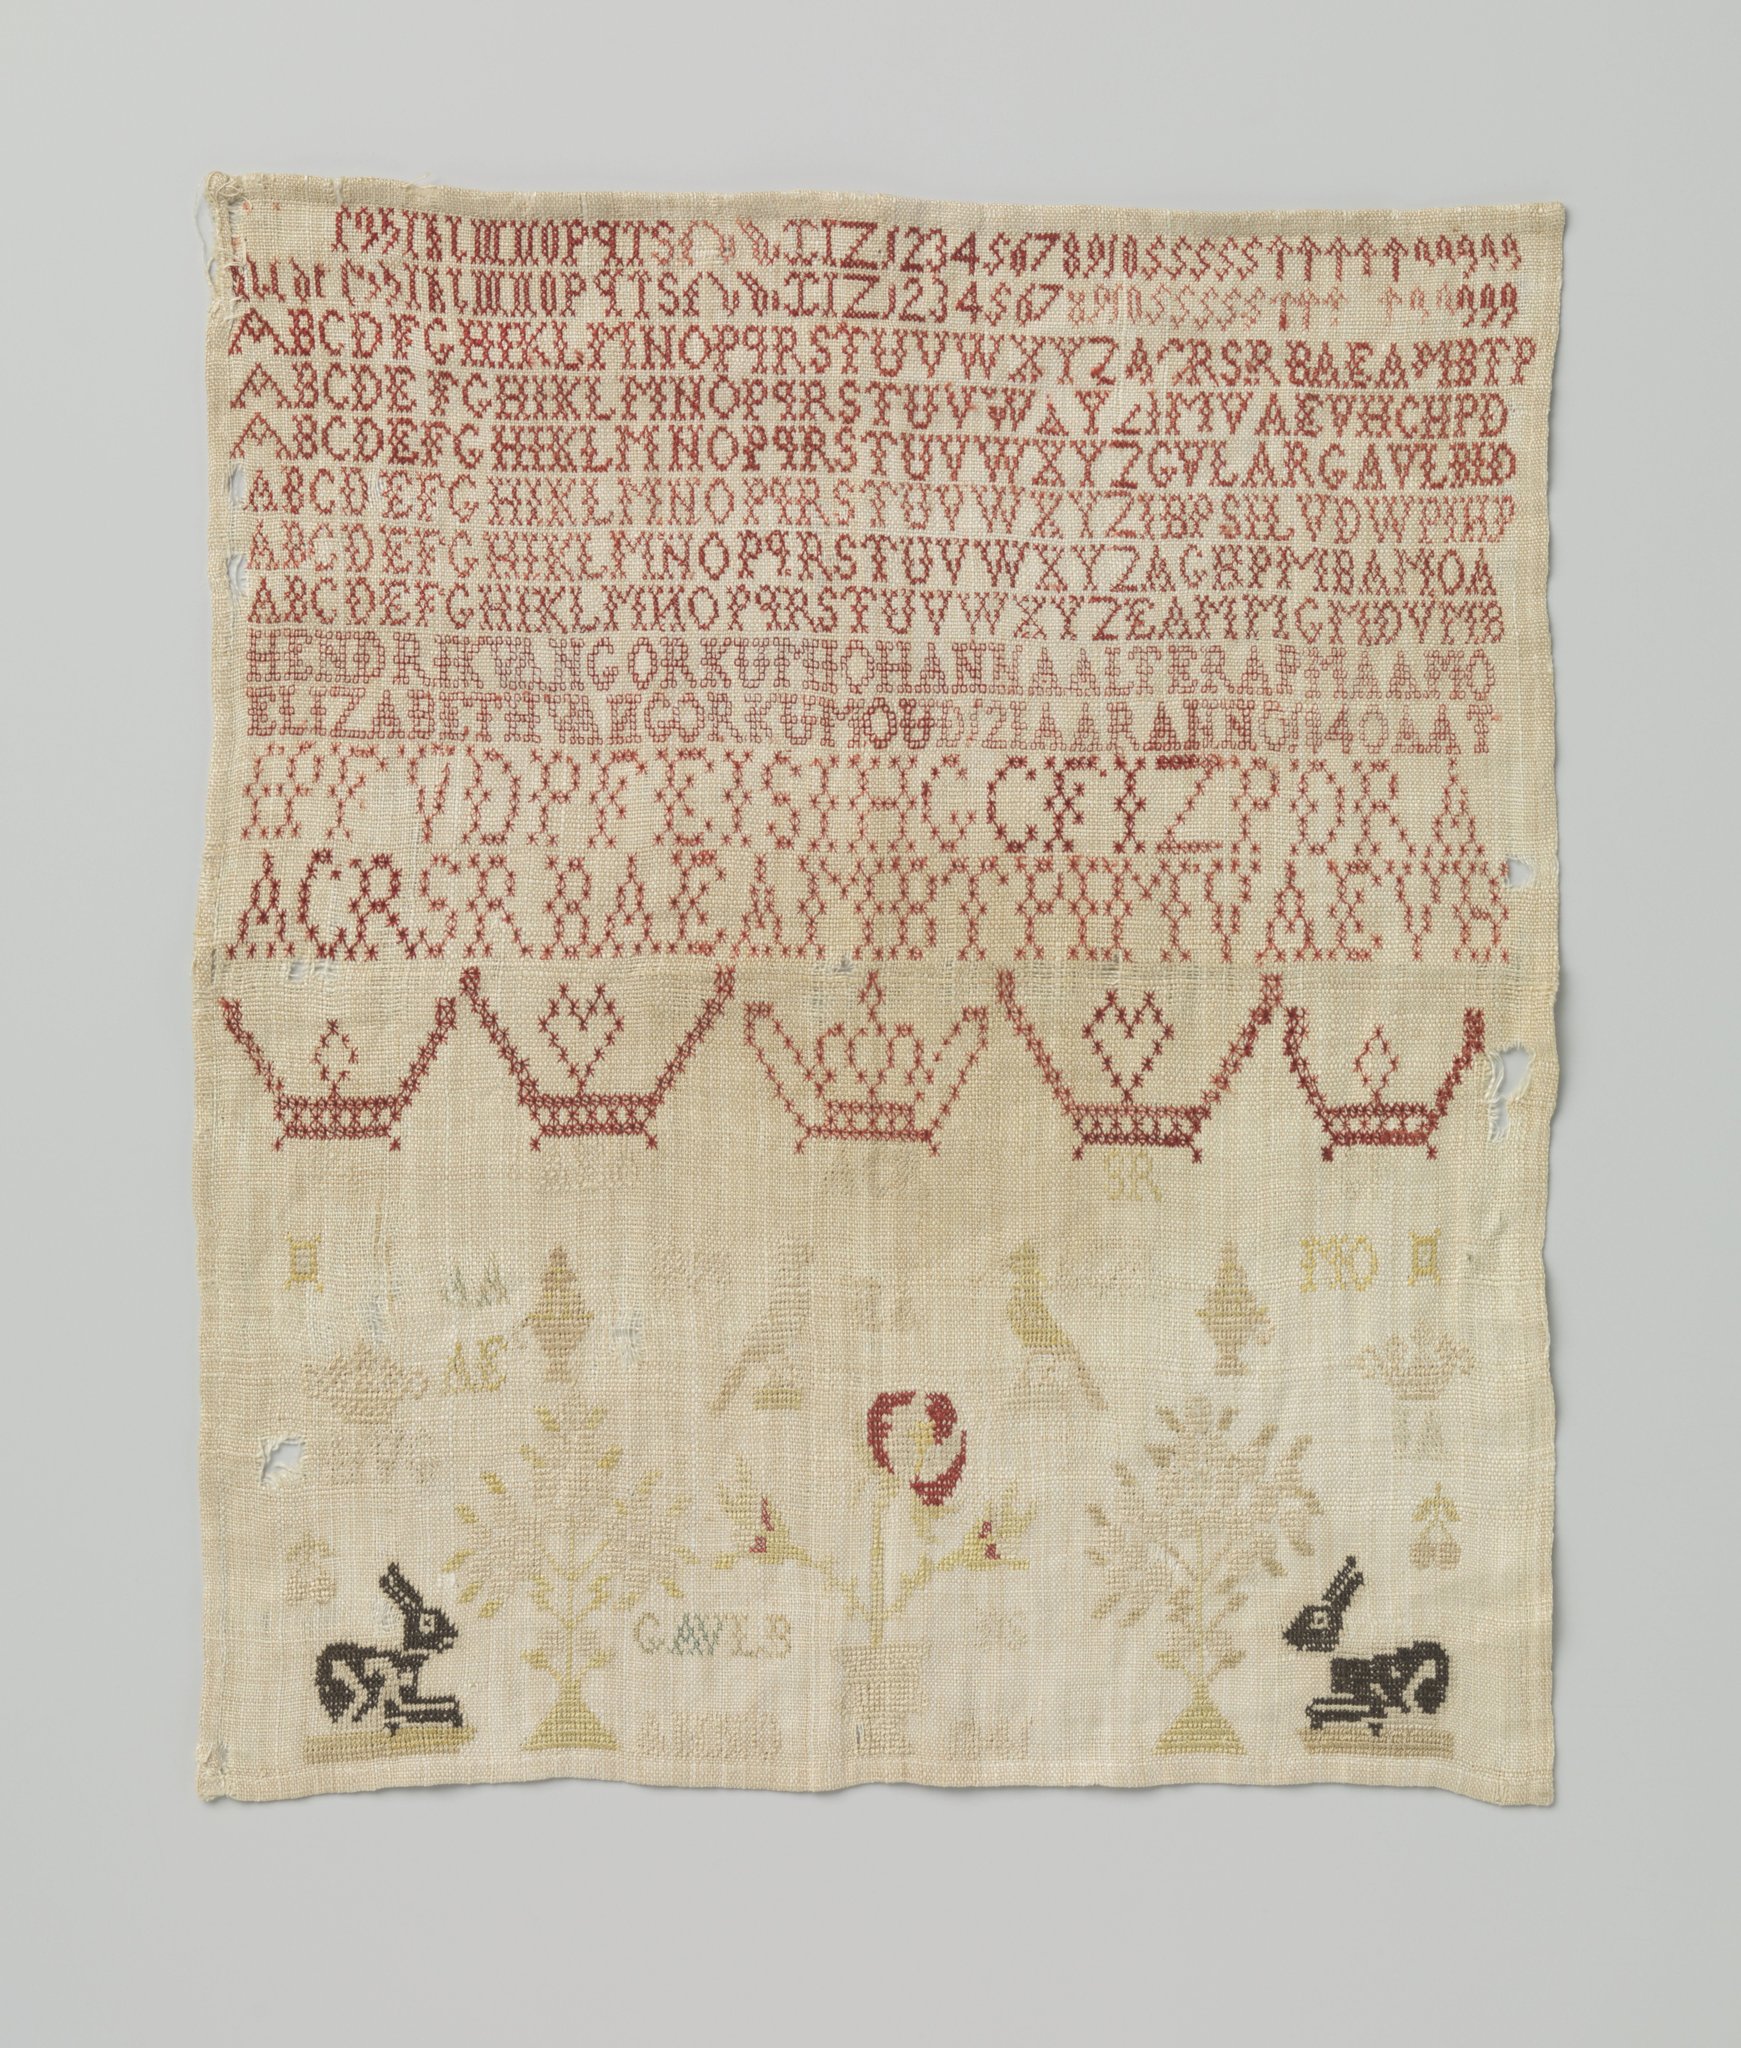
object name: merkdoek, merklap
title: Merklap van zijde op linnen.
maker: elizabeth gorhum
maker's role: borduurster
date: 1840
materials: linen, silk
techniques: embroidered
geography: amsterdam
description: Merklap van zijde op linnen. Het borduurwerk heeft de tekst: ELIZABETH VAN GORHUM OUD 12 JAAR ANNO 1840, achtmaal het alfabet, initialen en op de onderste regel: ANNO 1841.